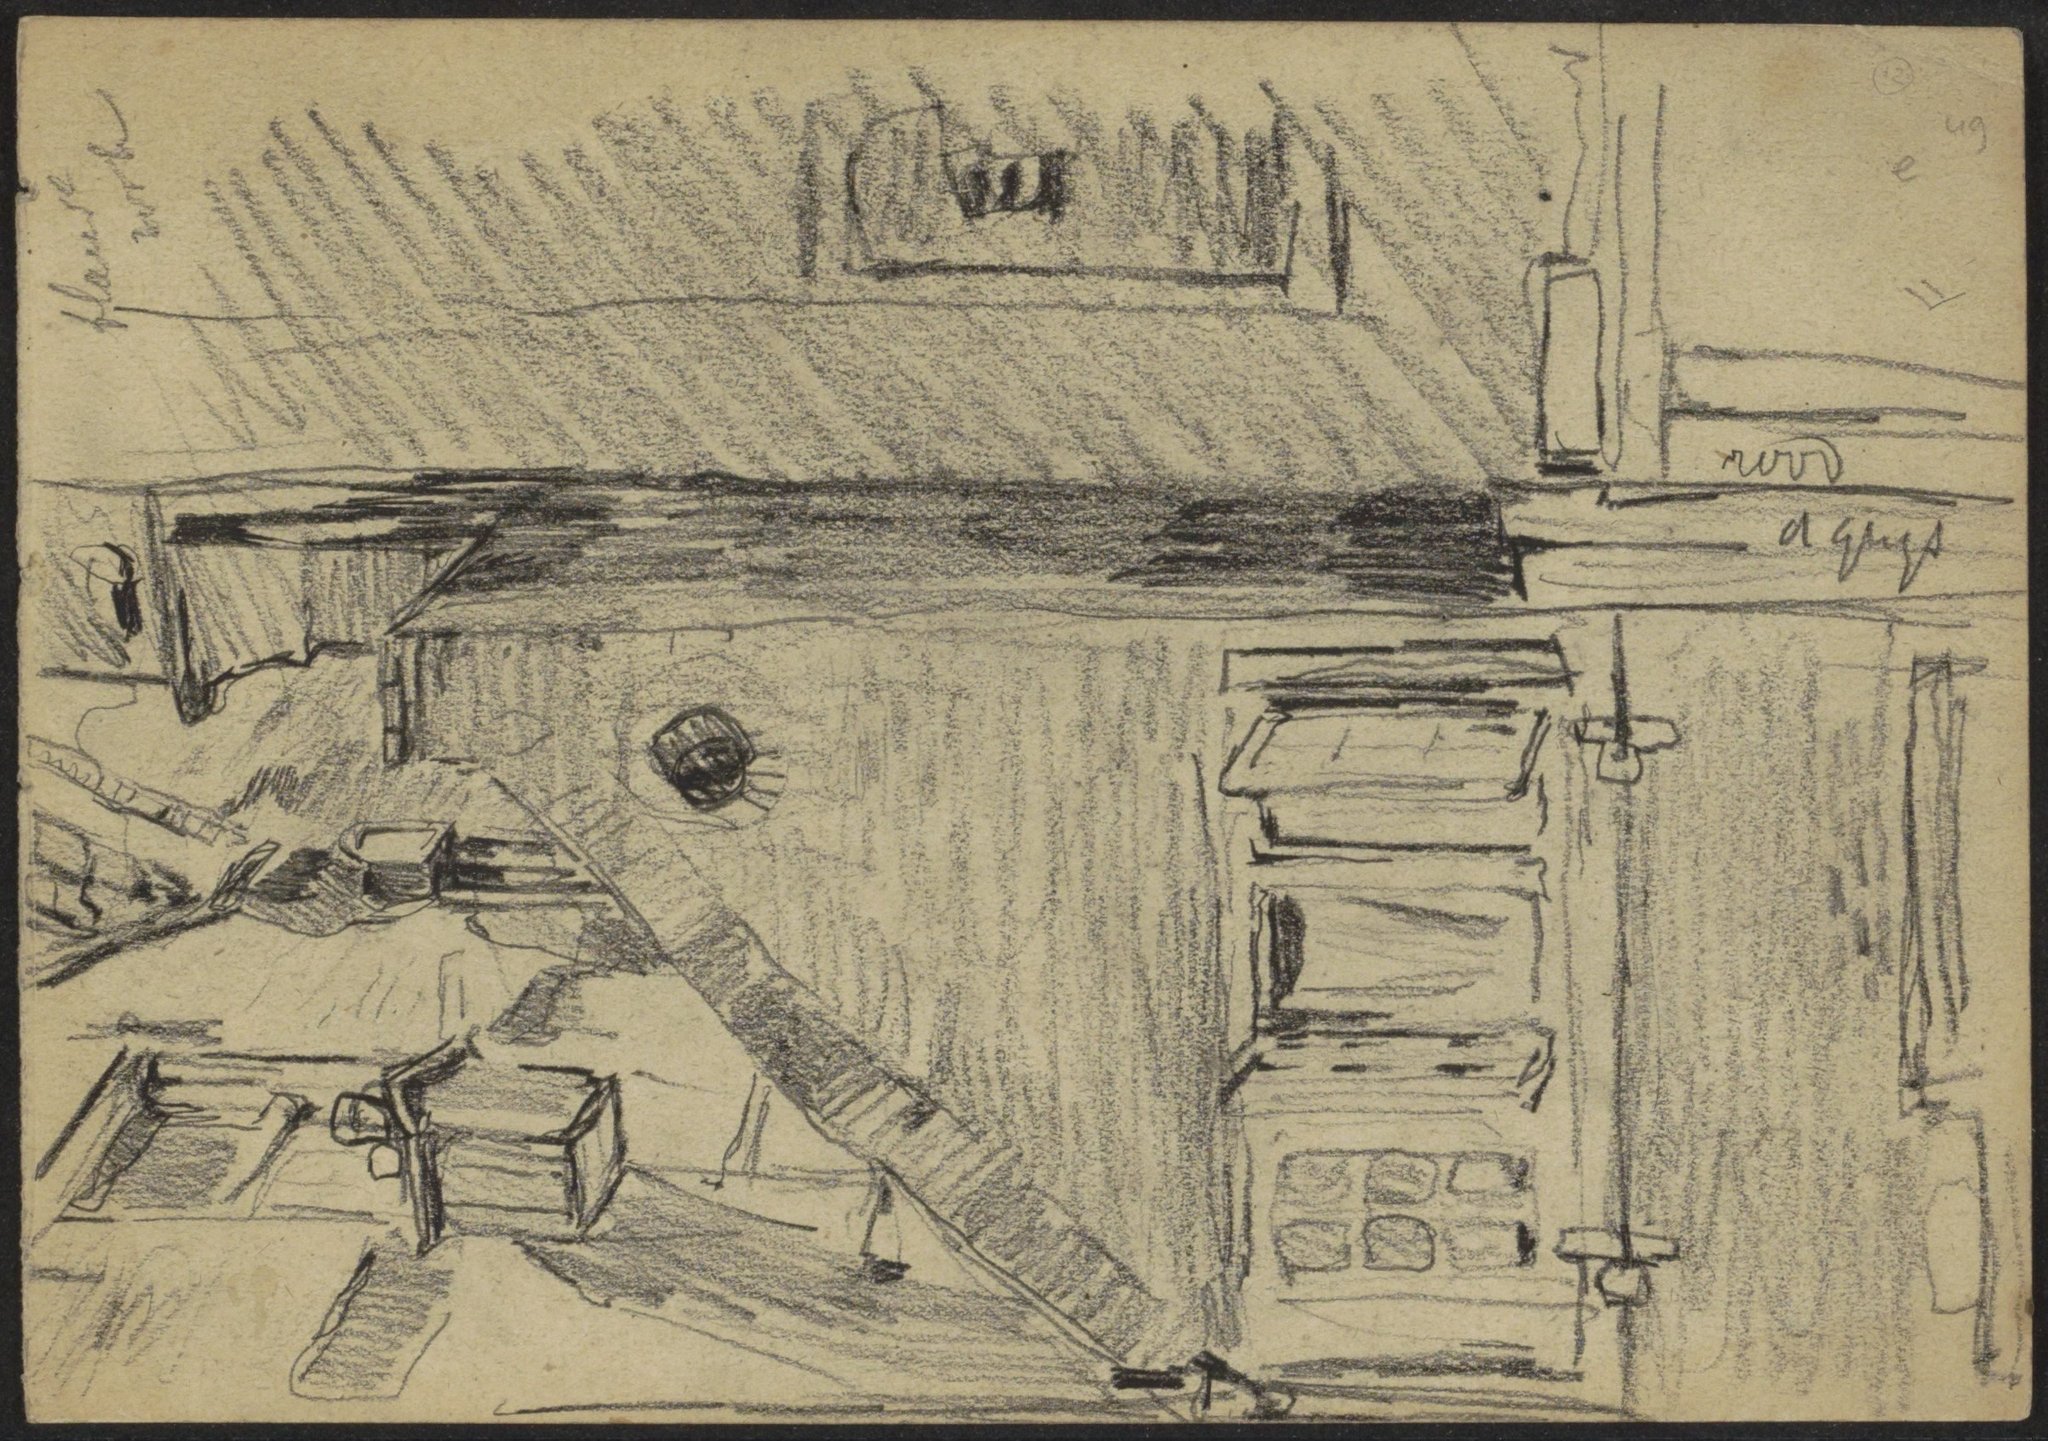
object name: sketchbook leaf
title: Façade van Krom Boomssloot 71 in Amsterdam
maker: willem witsen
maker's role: draughtsman, painter, print maker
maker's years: 1860-1923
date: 1907-1909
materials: paper, pencil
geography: amsterdam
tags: façade (of house or building)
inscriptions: : ‘[...]’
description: Witsen begon met het vervaardigen van de prenten in september 1907.